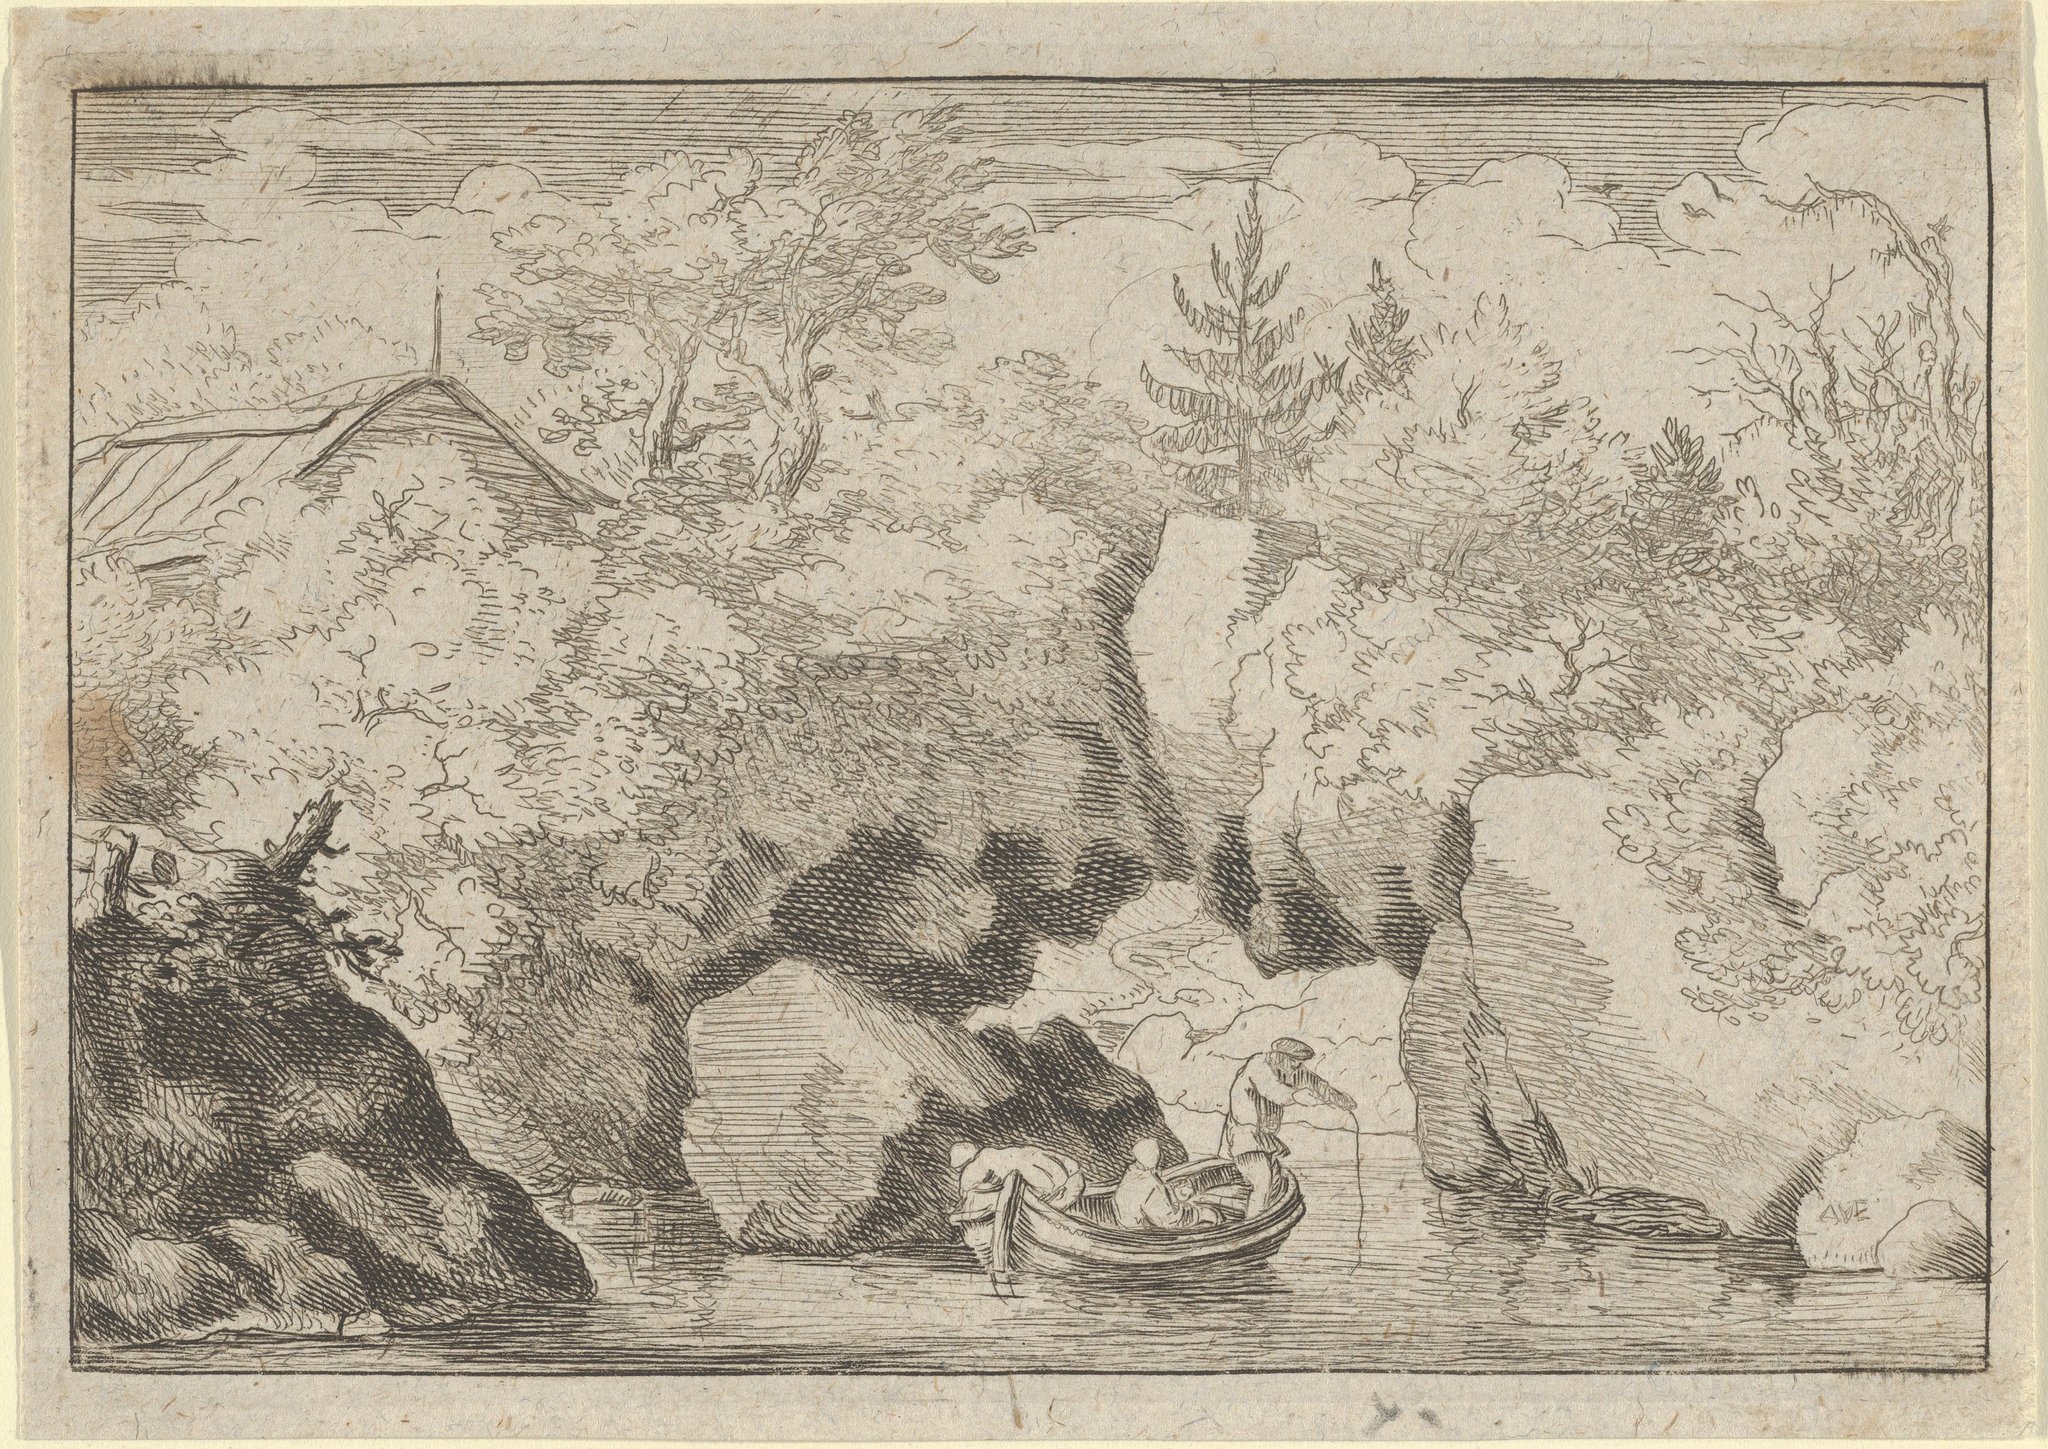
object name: print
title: The Skiff near the Pierced Rock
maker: allart van everdingen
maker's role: artist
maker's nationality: dutch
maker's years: 1621-1675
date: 1621-1675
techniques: engraving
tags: human figures,landscapes,boats